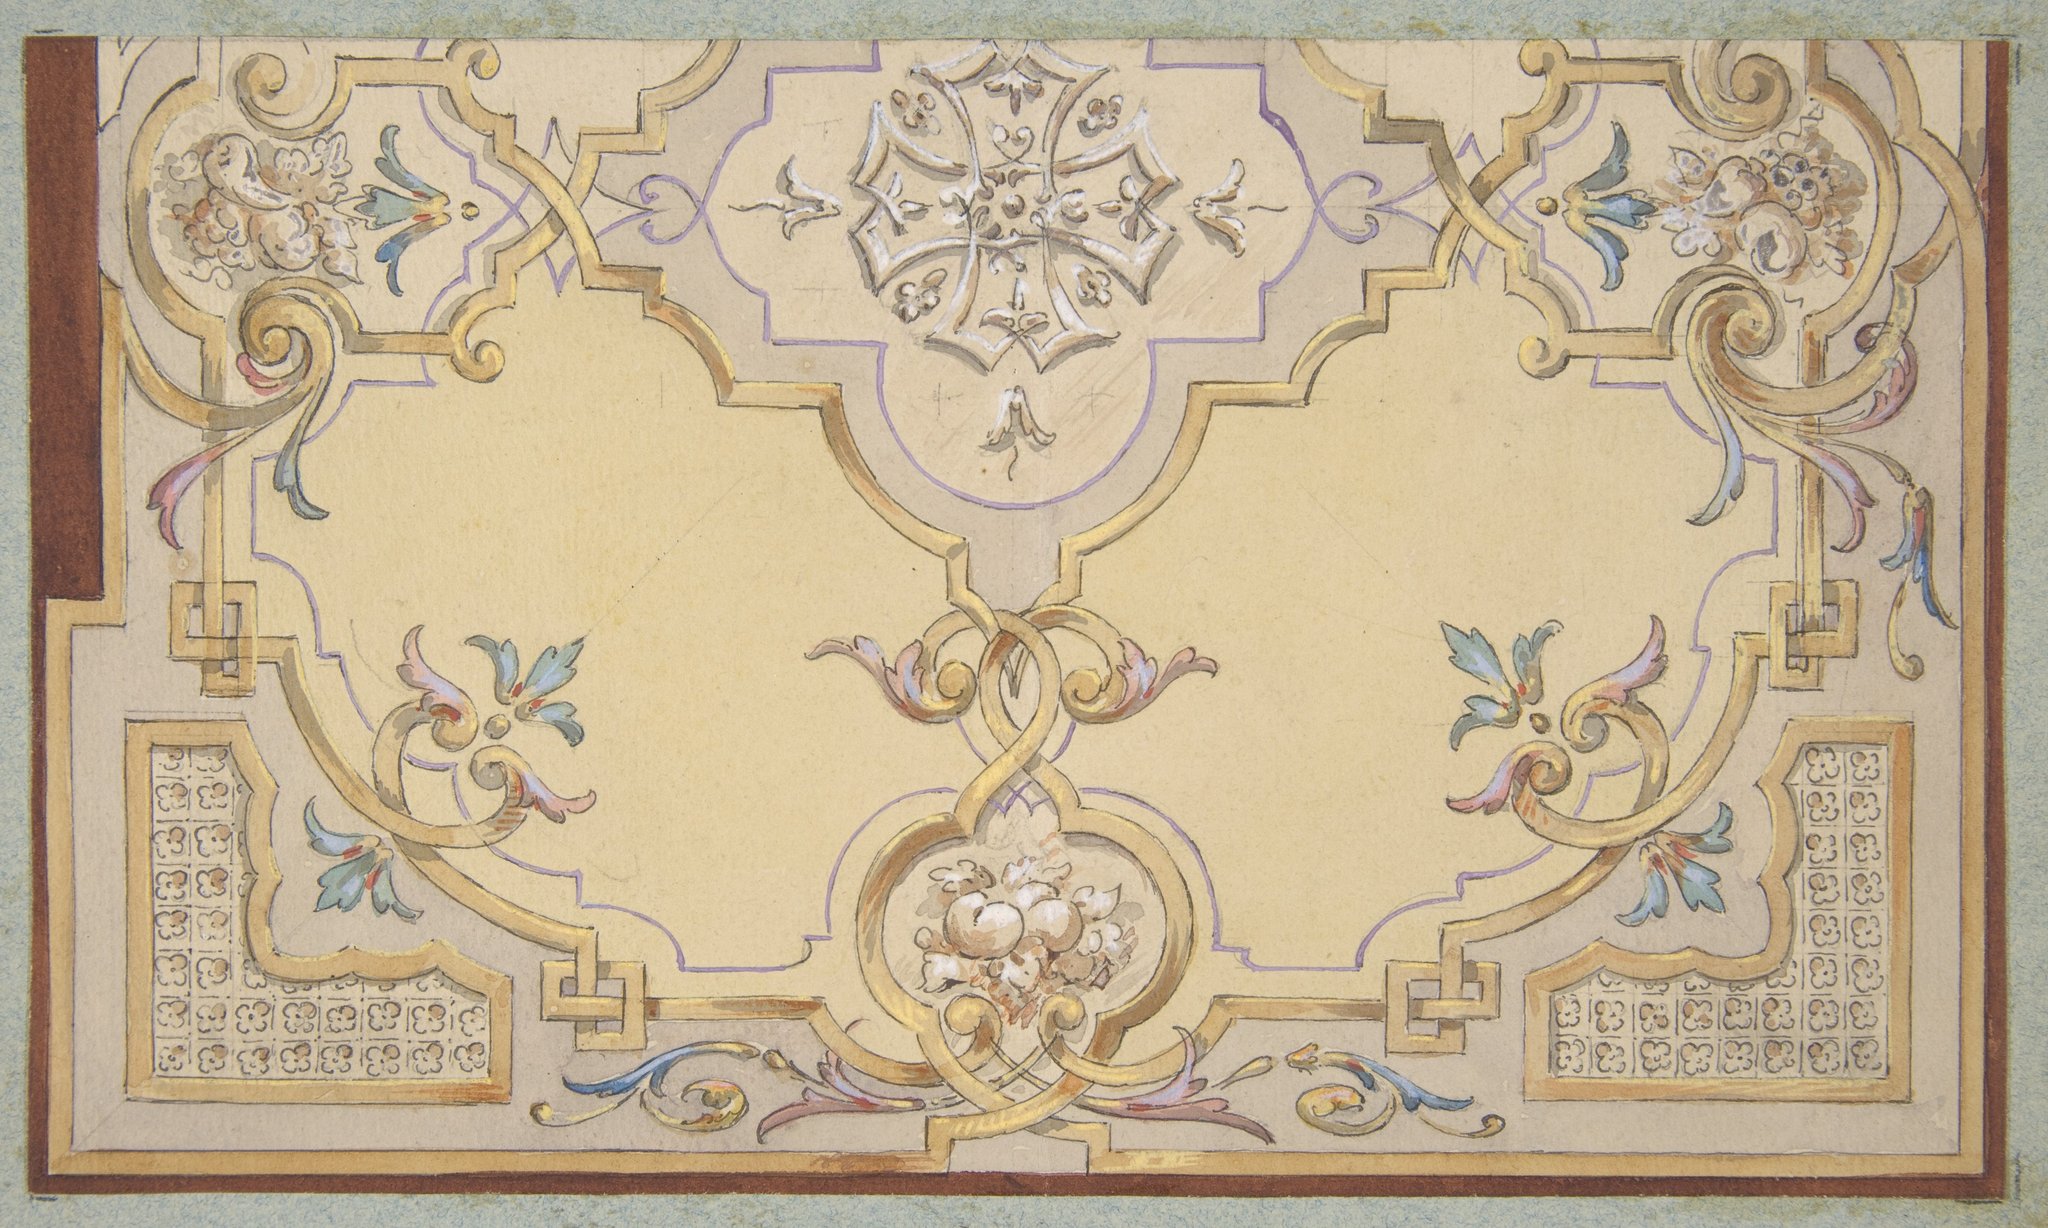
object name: drawing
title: Partial design for the decoration of a ceiling with scrolls and swags of fruit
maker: jules-edmond-charles lachaise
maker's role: artist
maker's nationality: french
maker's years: 1897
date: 1830-1897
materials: gouache, graphite, ink, watercolor, paper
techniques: pen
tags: ceilings